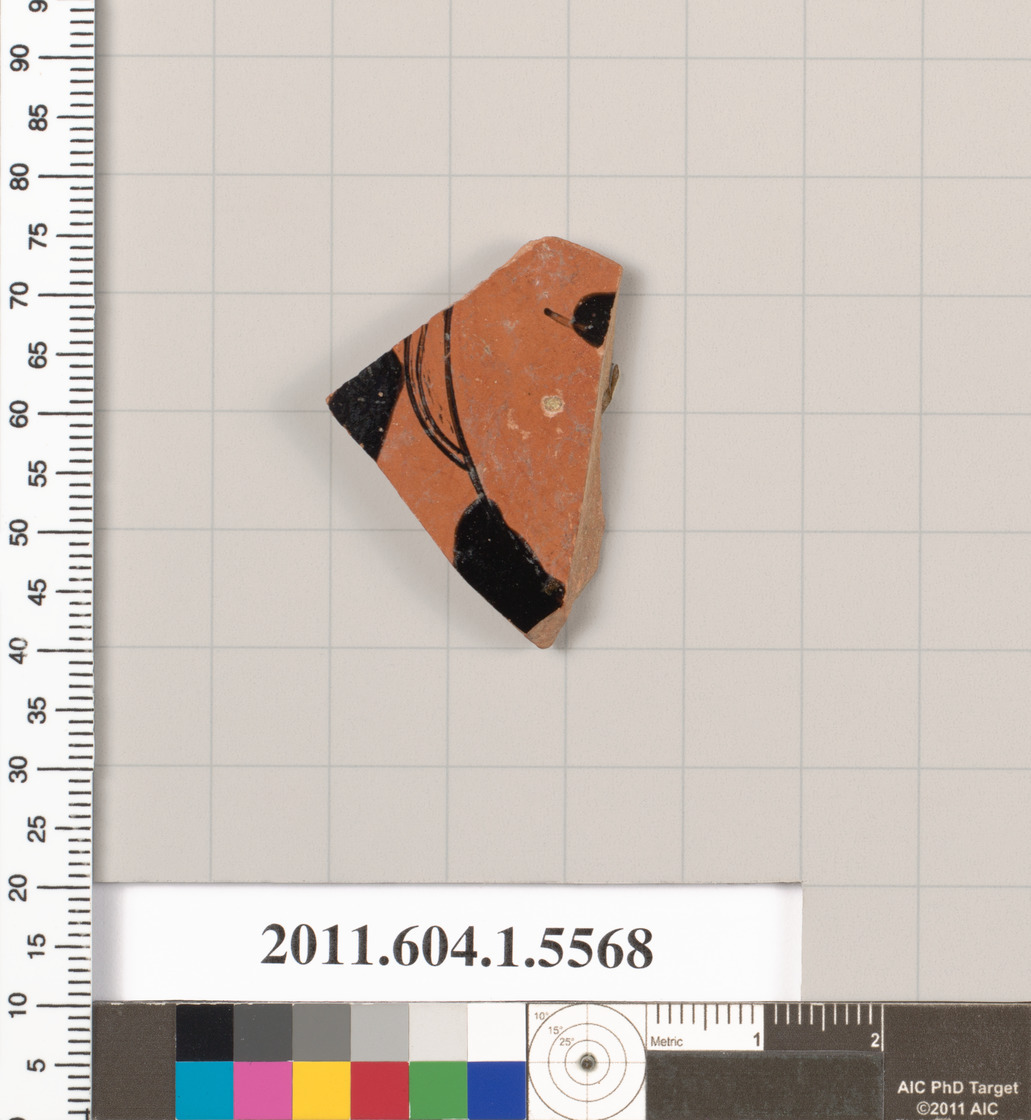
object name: kylix fragment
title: Terracotta fragment of a kylix (drinking cup)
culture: greek, attic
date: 510-490 BCE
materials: terracotta